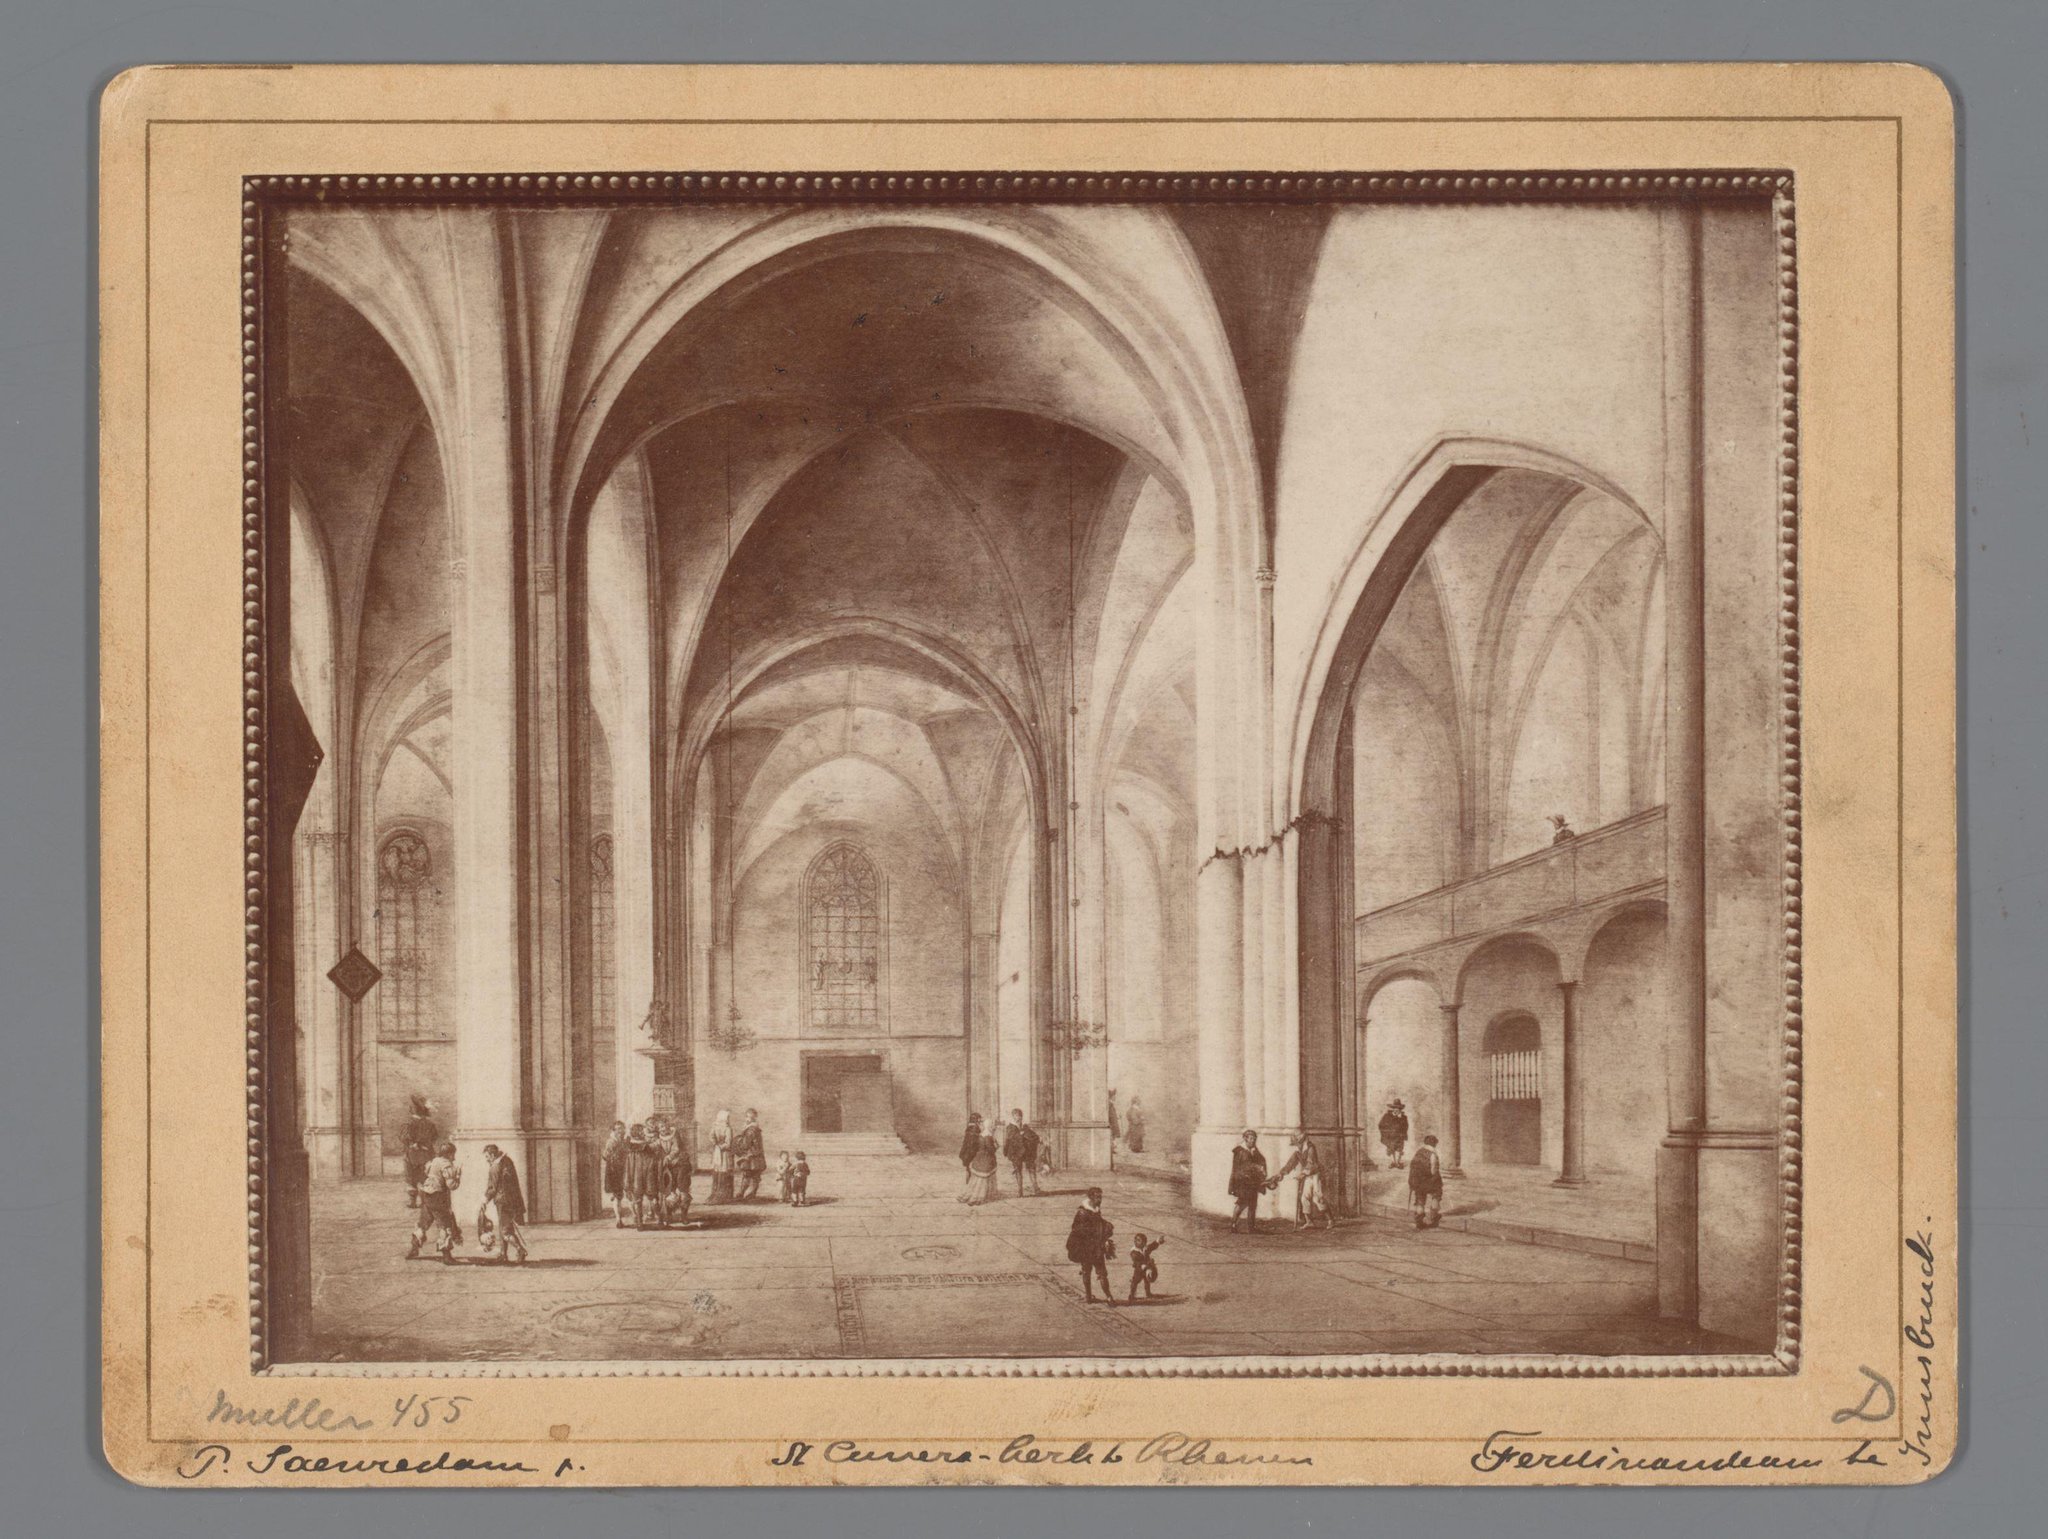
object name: reproduction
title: Fotoreproductie van een schilderij van het interieur van de Cunerakerk te Rhenen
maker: Anonymous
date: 1860-1900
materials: cardboard, photographic support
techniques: albumen print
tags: interior of church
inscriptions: annotation: ‘Muller 455/ P. Saenredam/ St. Cunera-kerk Rhenen/ Ferdinandeum te Innsbruck’